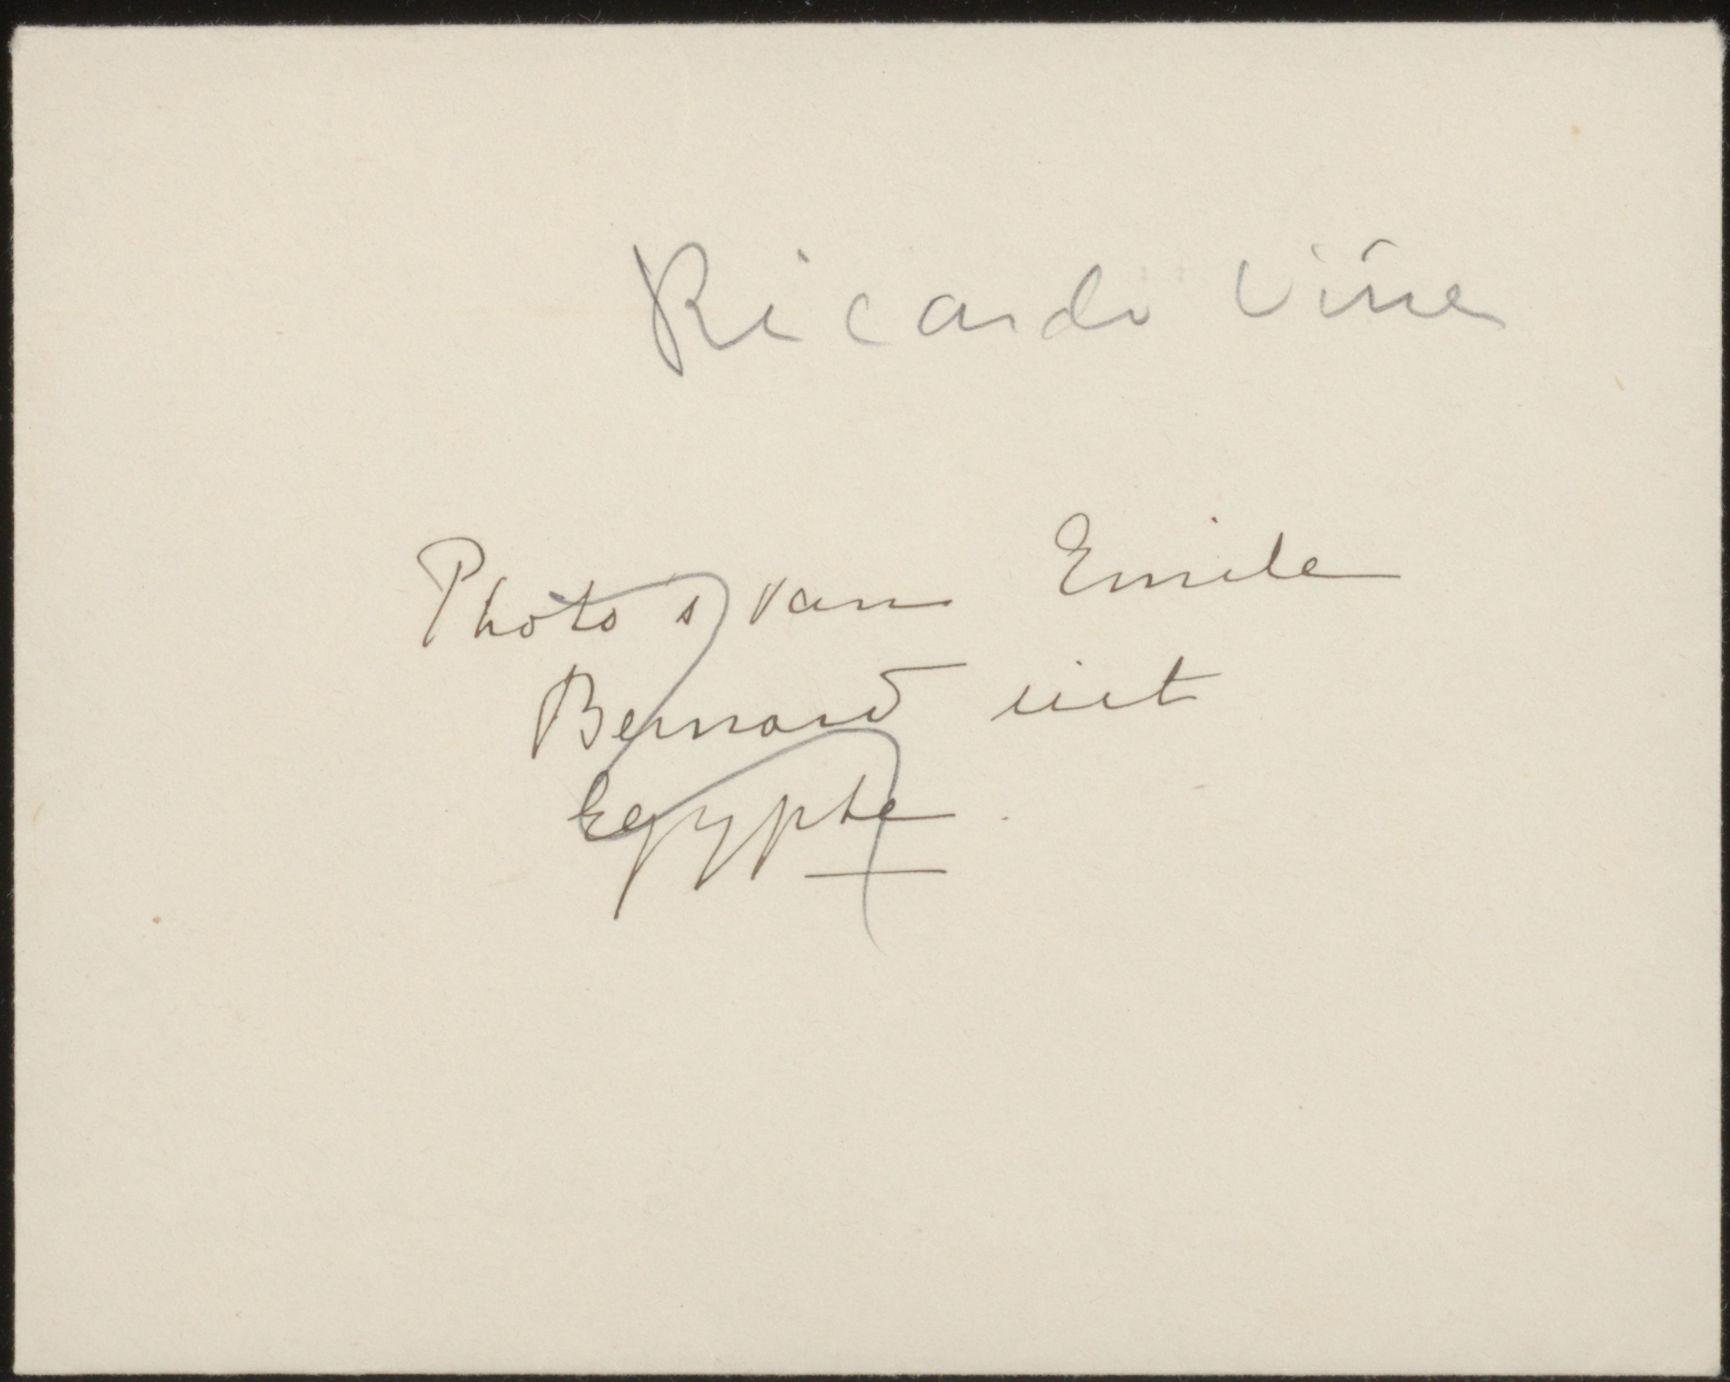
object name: envelope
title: Envelop van Andries Bonger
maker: Anonymous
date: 1871-1936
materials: ink, paper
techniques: pen, writing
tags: ricardo viñes, lille, paris, print maker, émile bernard, andries bonger, photography, cinematography